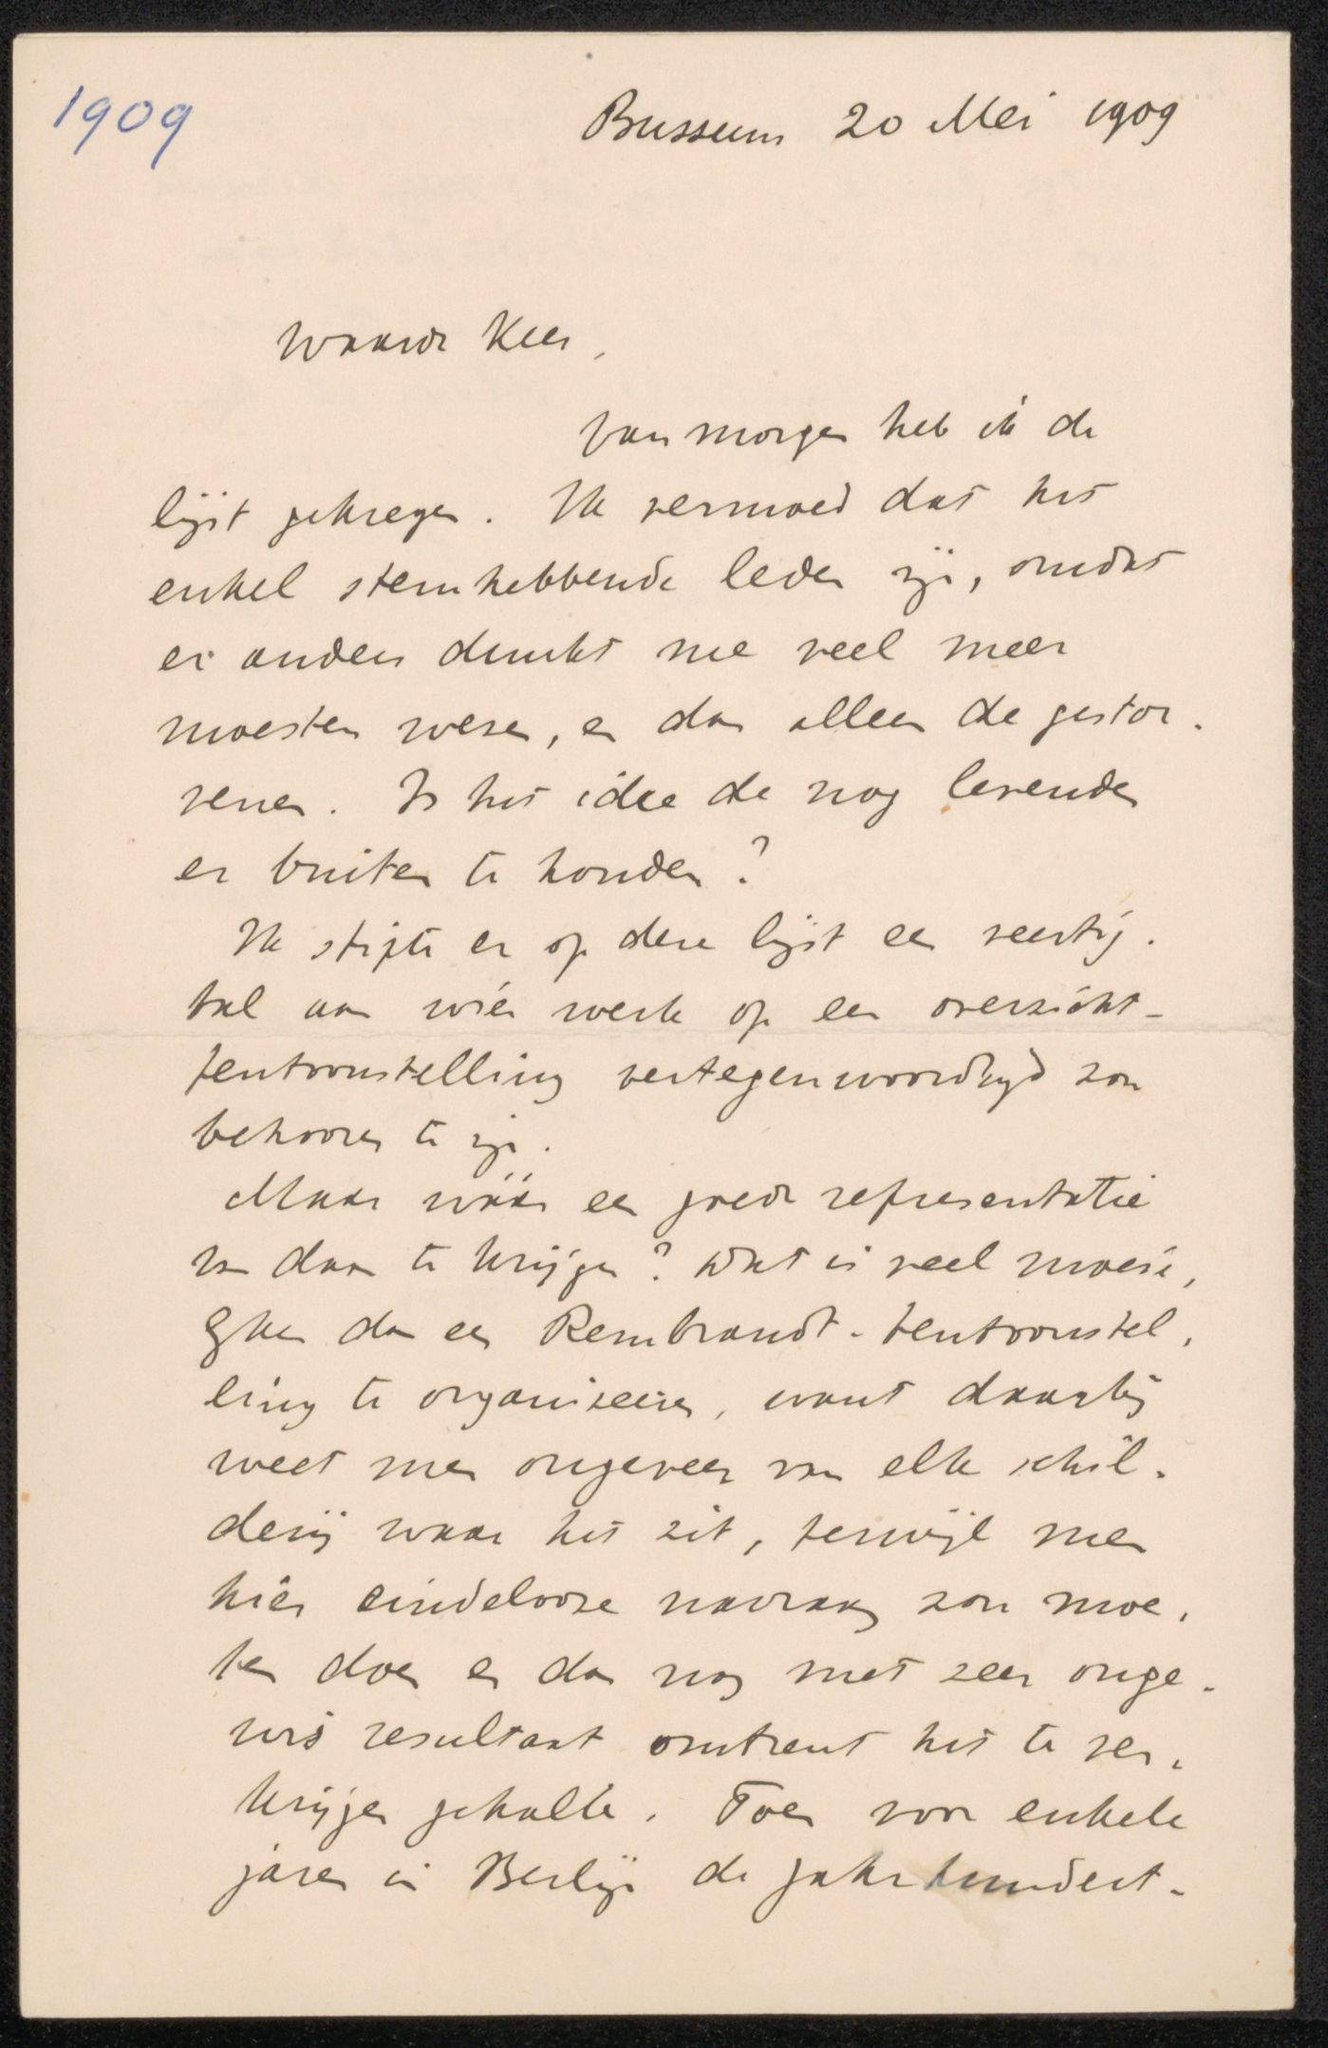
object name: letter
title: Brief aan Cornelis Gerardus 't Hooft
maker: jan veth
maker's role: designer, draughtsman, painter, print maker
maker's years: 1864-1925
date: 1909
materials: ink, paper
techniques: pen, writing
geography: bussum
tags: cornelis gerardus 't hooft, anonymous historical person portrayed, painting (including book-illumination, miniature-painting), exhibition ~ art, berlin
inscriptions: watermark, collector's mark: ‘RPK’